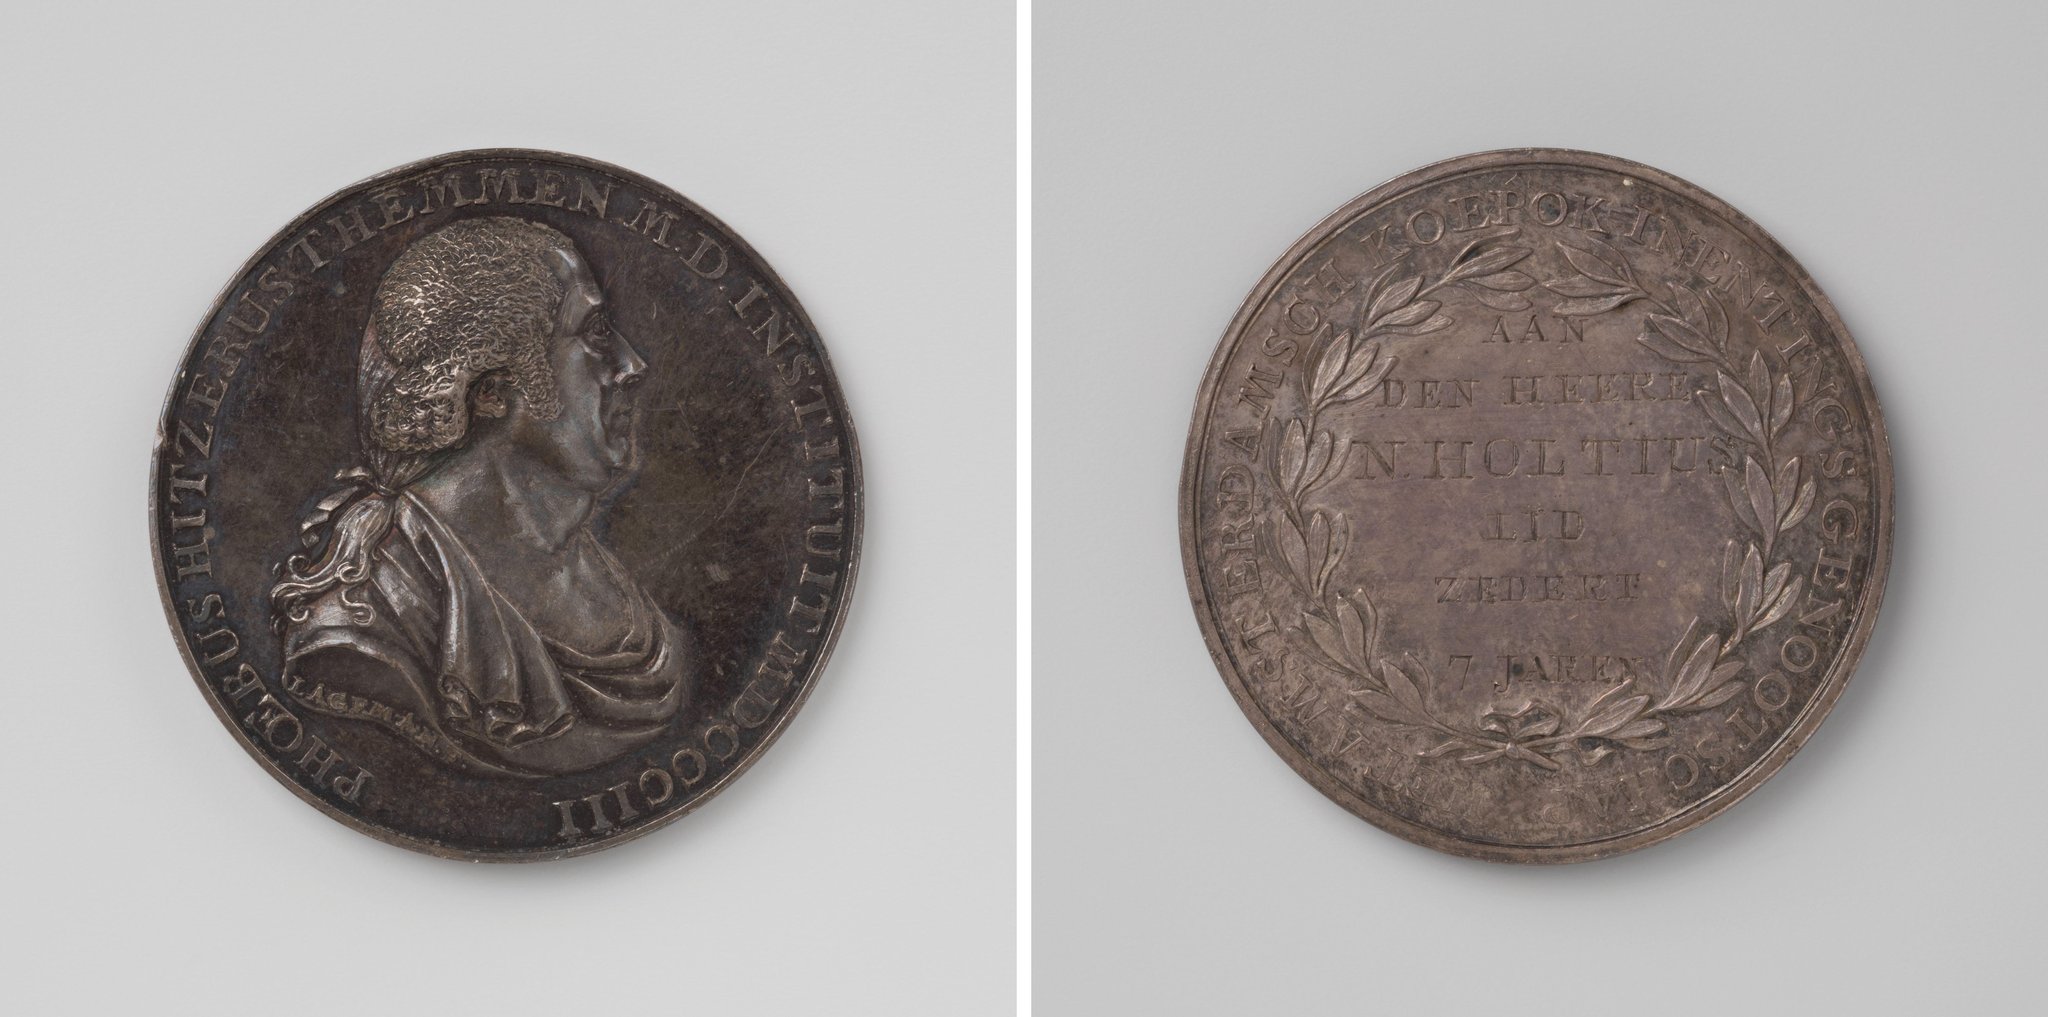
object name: honorary medal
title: Zevenjarig bestaan van het Genootschap tot Bevordering der Koepokinenting te Amsterdam, penning uitgereikt aan N. Holtius, lid vanaf de oprichting van het genootschap door P.H. Themmen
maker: johannes michiel lageman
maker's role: silversmith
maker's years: 1735-1809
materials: silver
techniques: engraving, striking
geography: amsterdam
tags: phoebus hitzerus themmen, amsterdam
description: Zilveren penning. Voorzijde: borststuk man binnen omschrift. Keerzijde: opschrift binnen lauwerkrans en omschrift